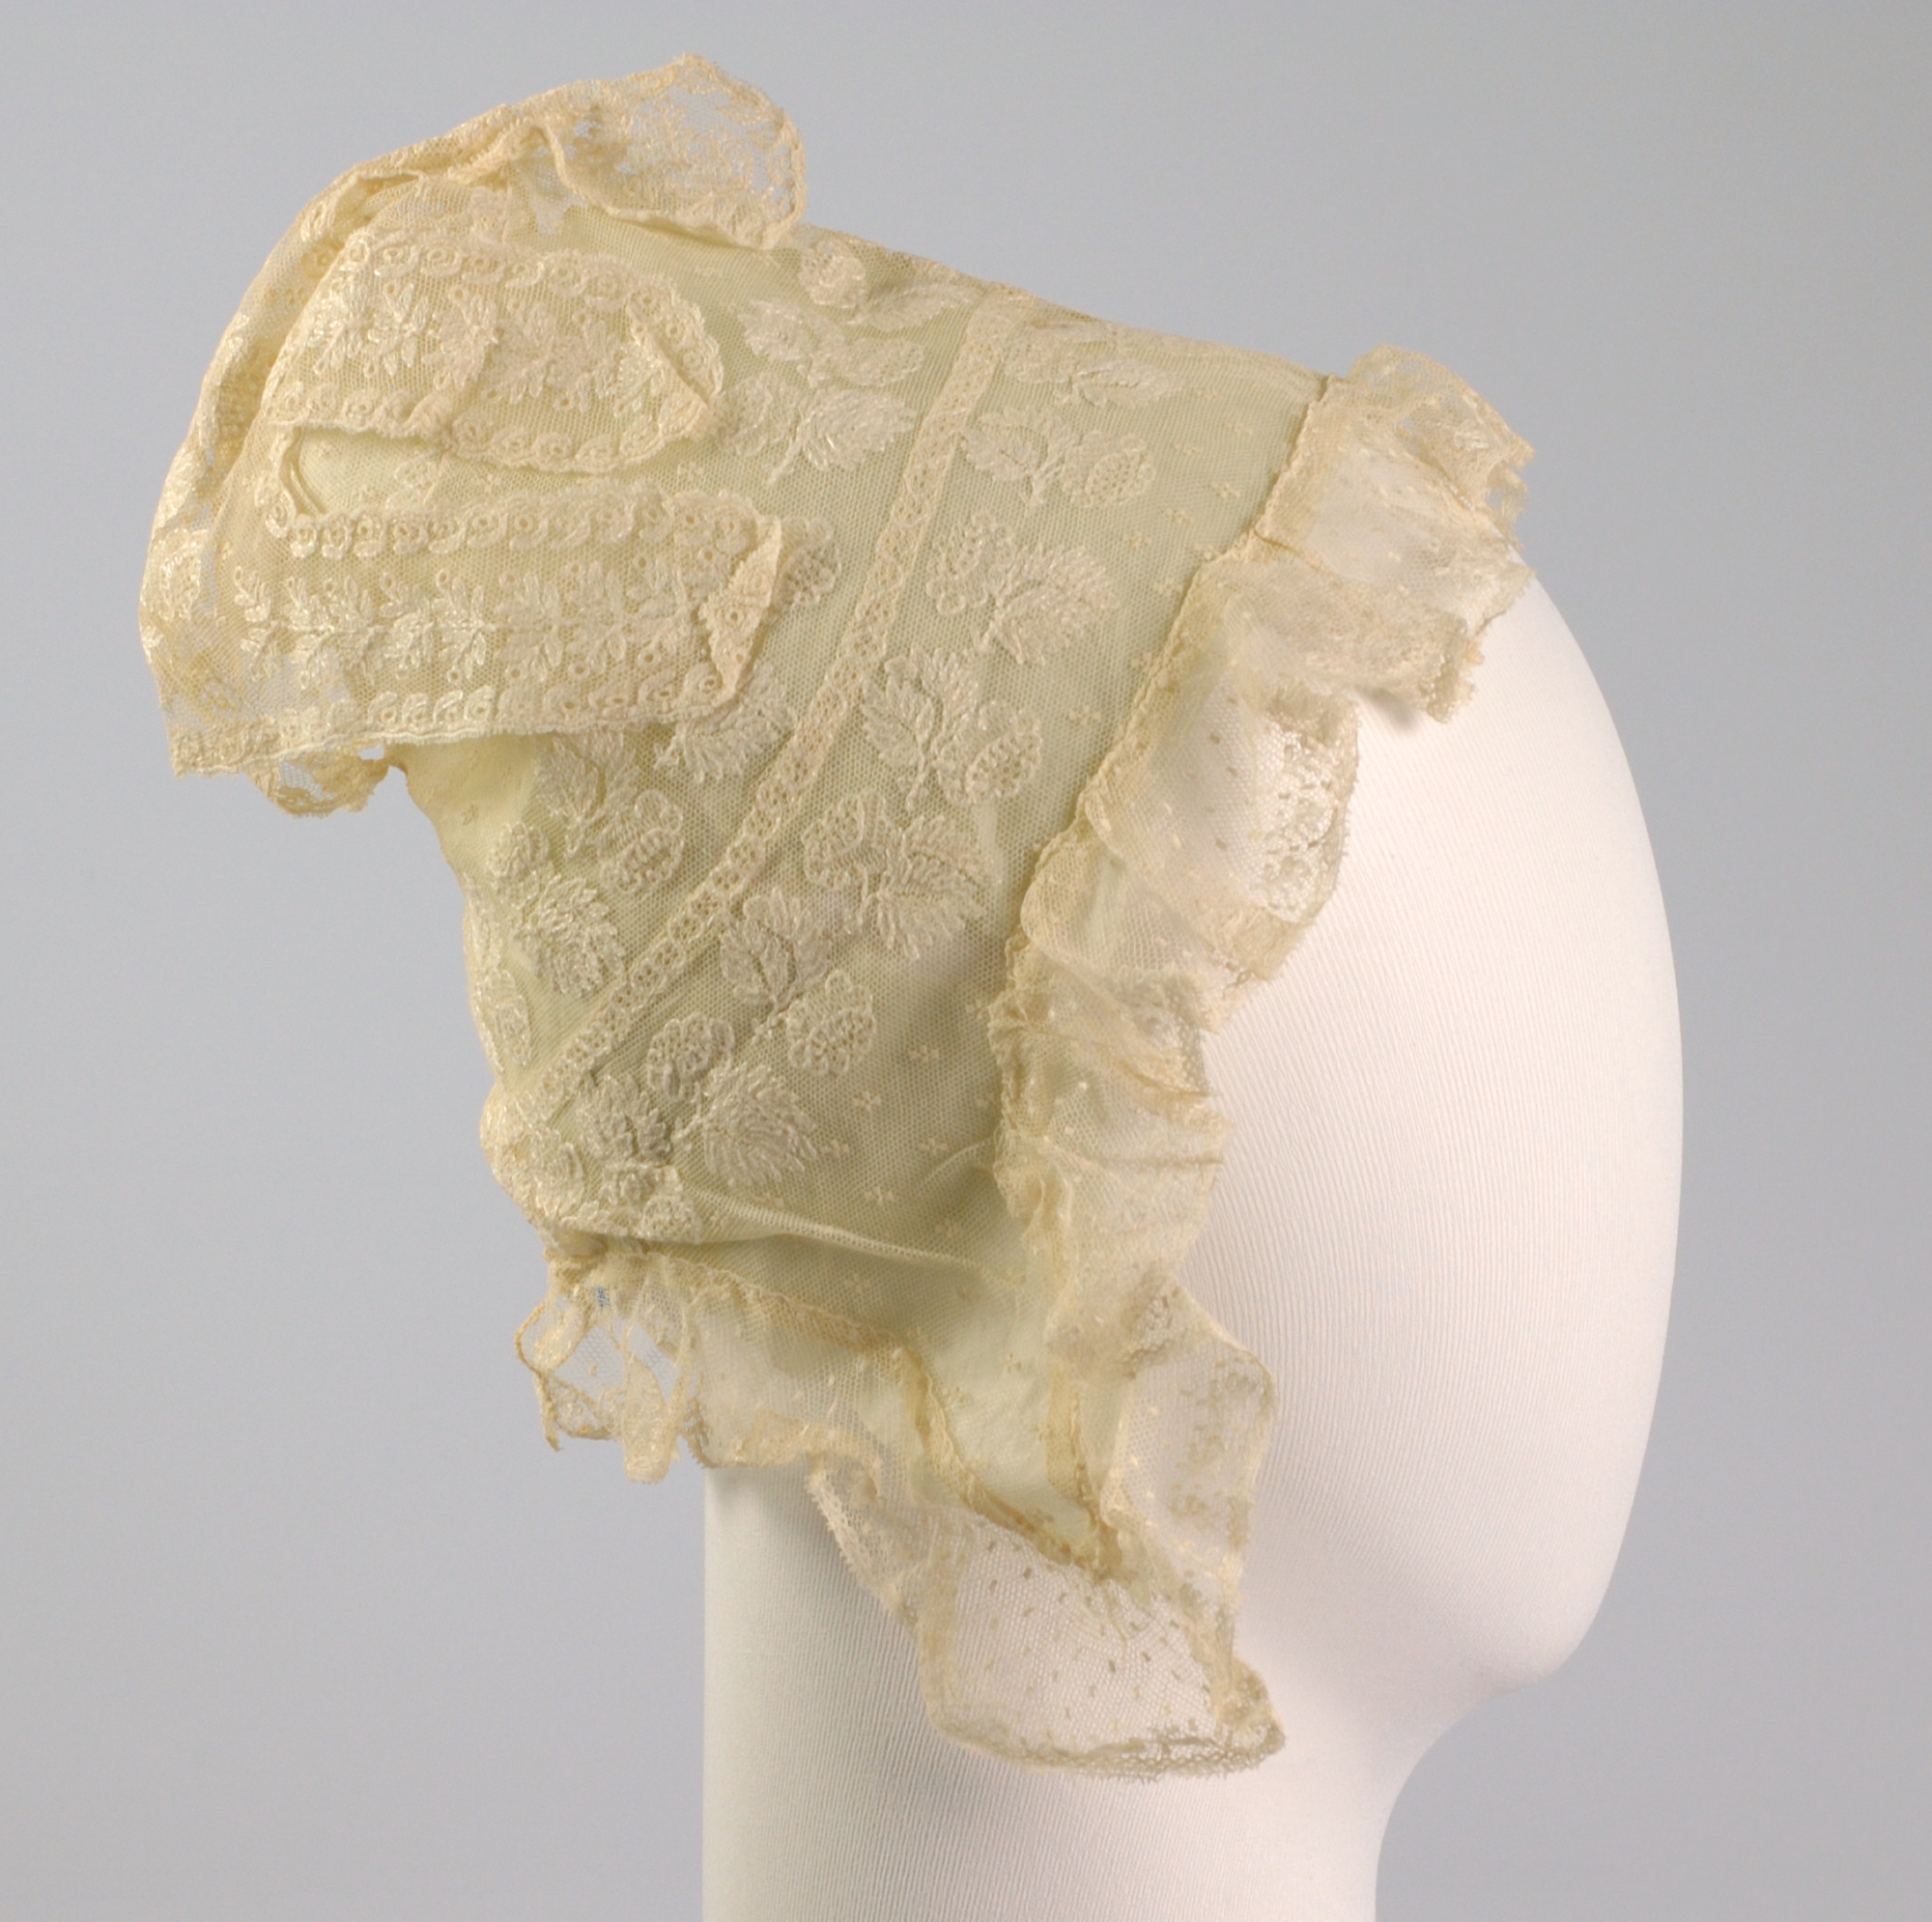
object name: cap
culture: american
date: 1810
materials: cotton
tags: flowers